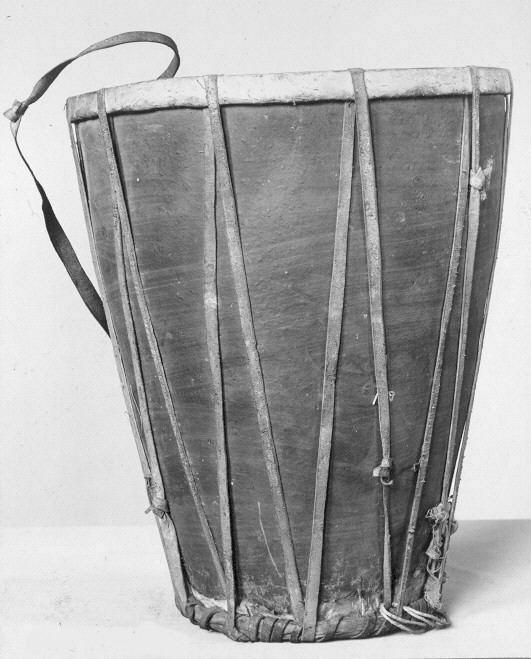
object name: banya drum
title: Banya (drum)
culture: indian, north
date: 1867-1900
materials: clay, skin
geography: india